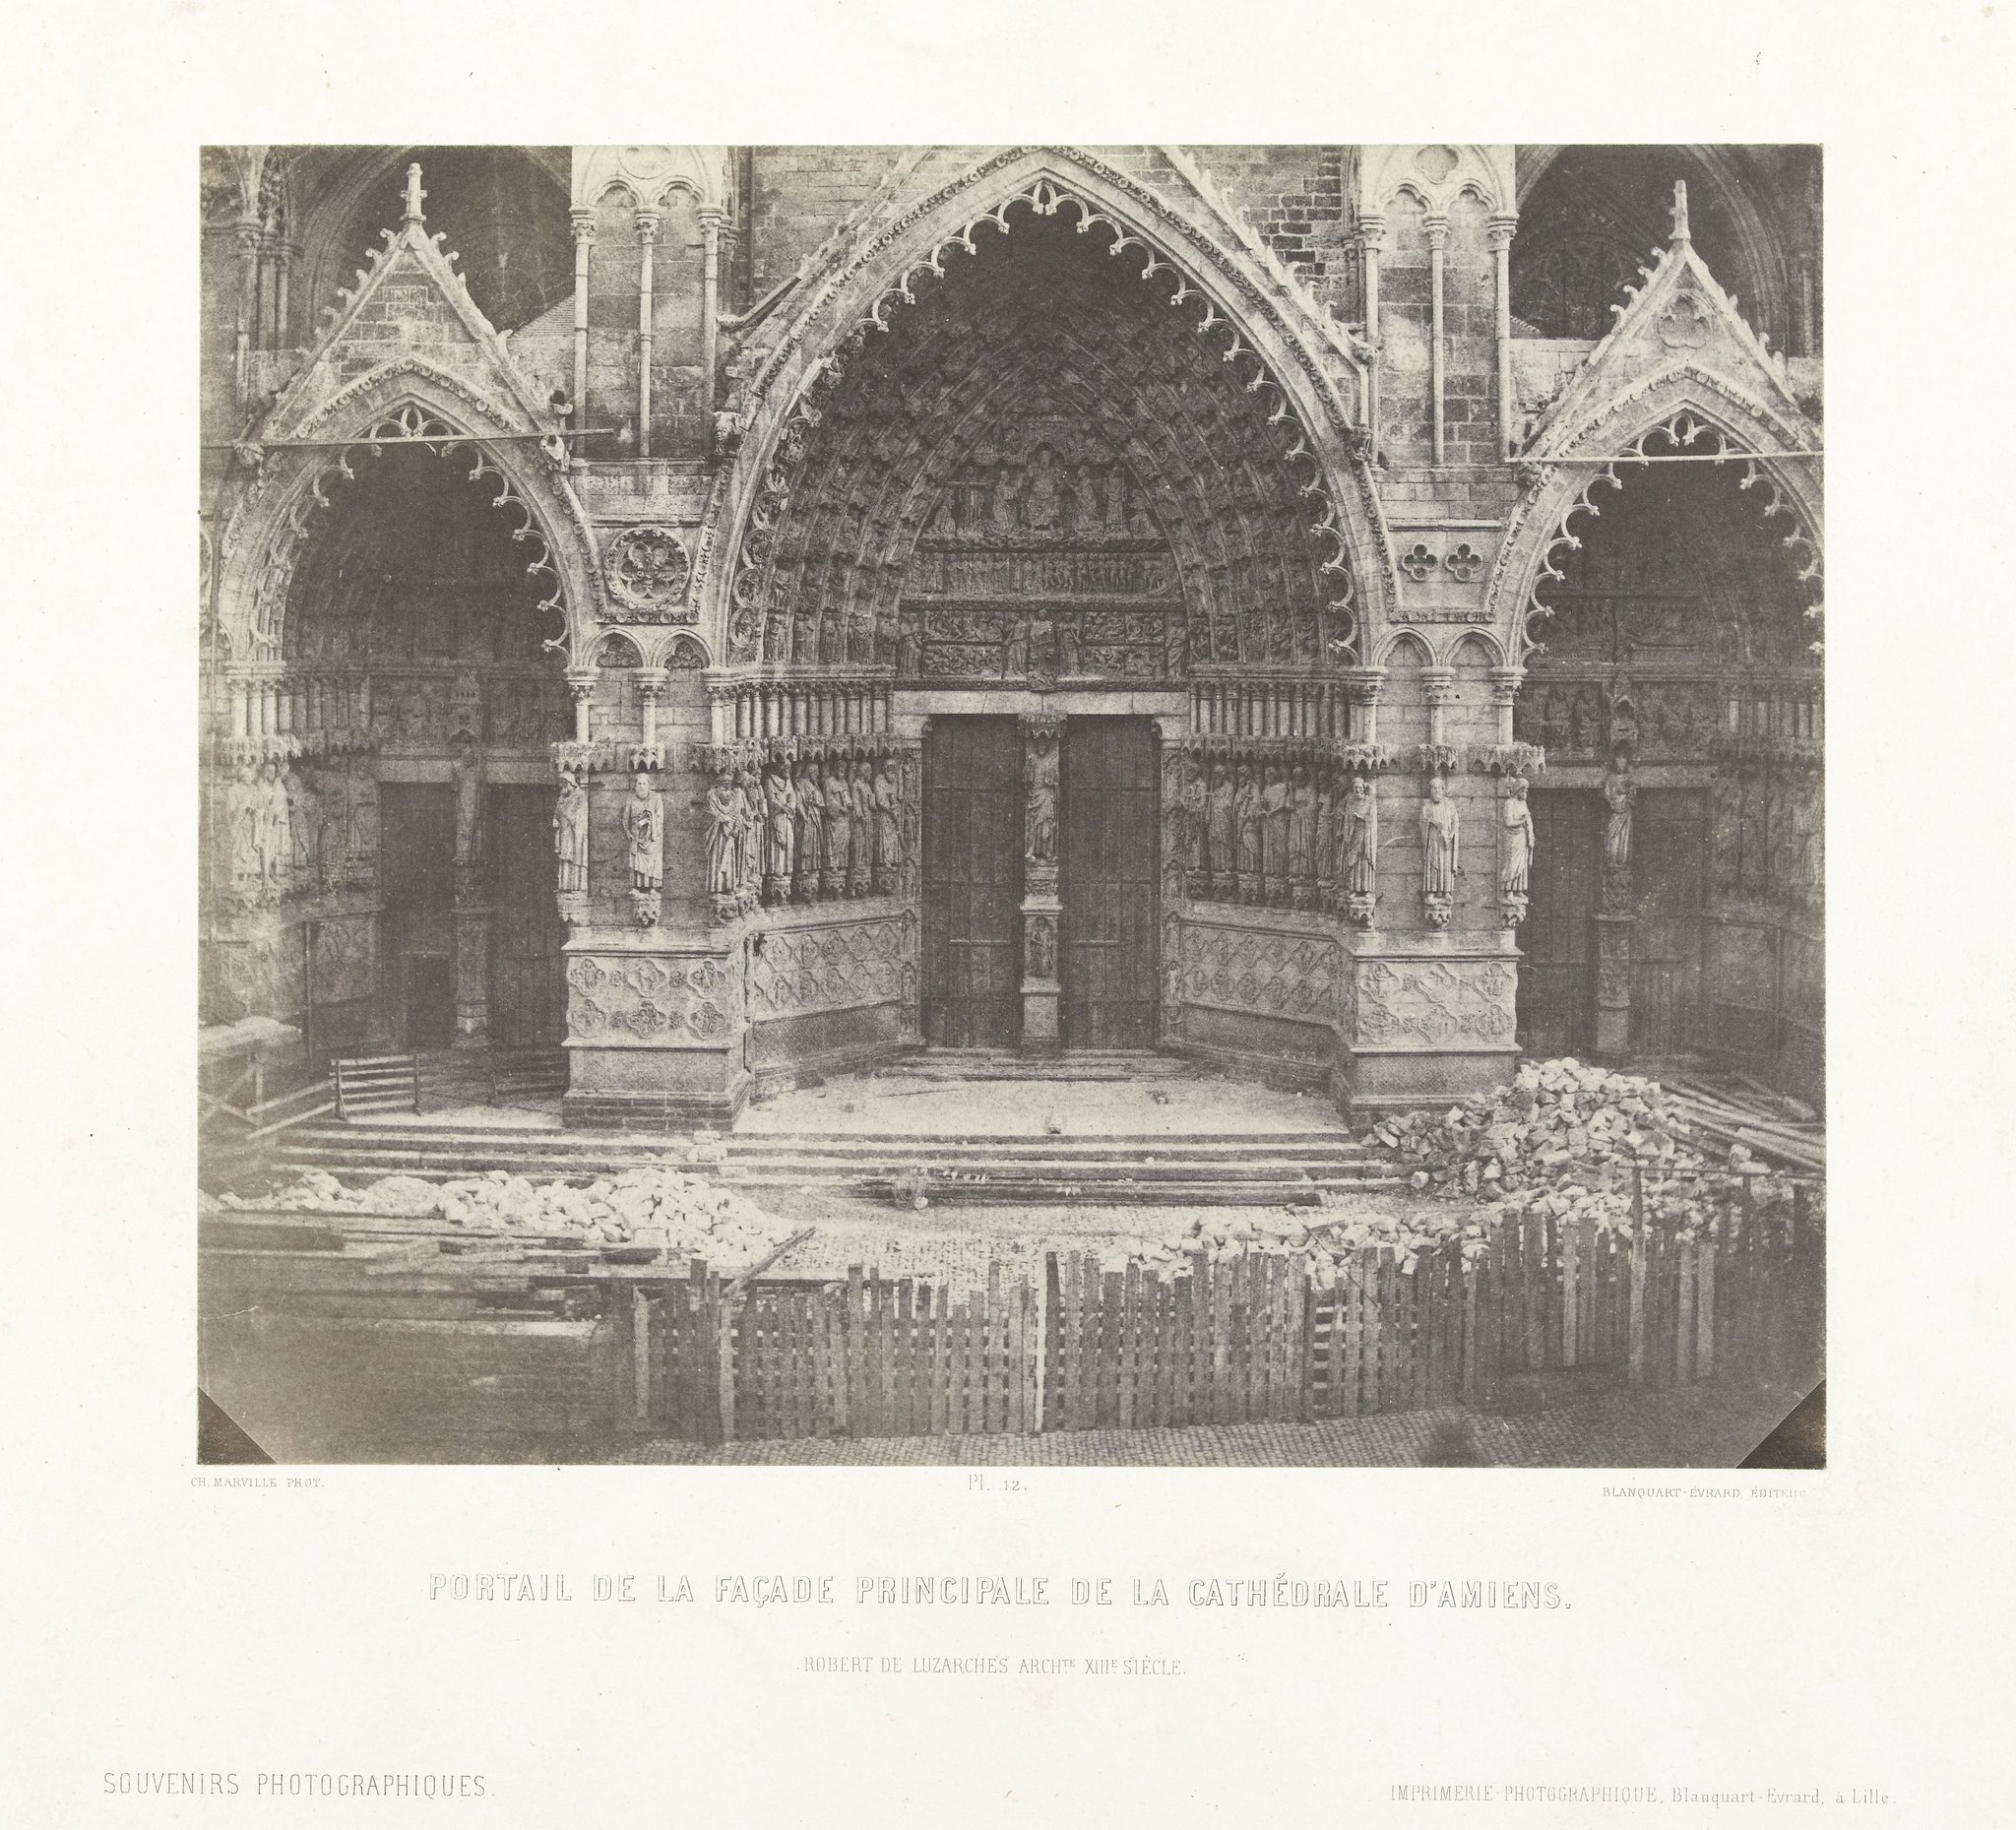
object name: photograph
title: Portail de la façade principale de la cathédrale d'Amiens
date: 1850-1853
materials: cardboard, paper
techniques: salted paper print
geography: lille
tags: parts of church exterior and annexes: portal, notre-dame d'amiens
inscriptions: inscription: ‘ROBERT DE LUZARCHES ARCHTE XIIIe SIÈCLE.’, number: ‘Pl. 12.’, inscription: ‘6928/ 33’